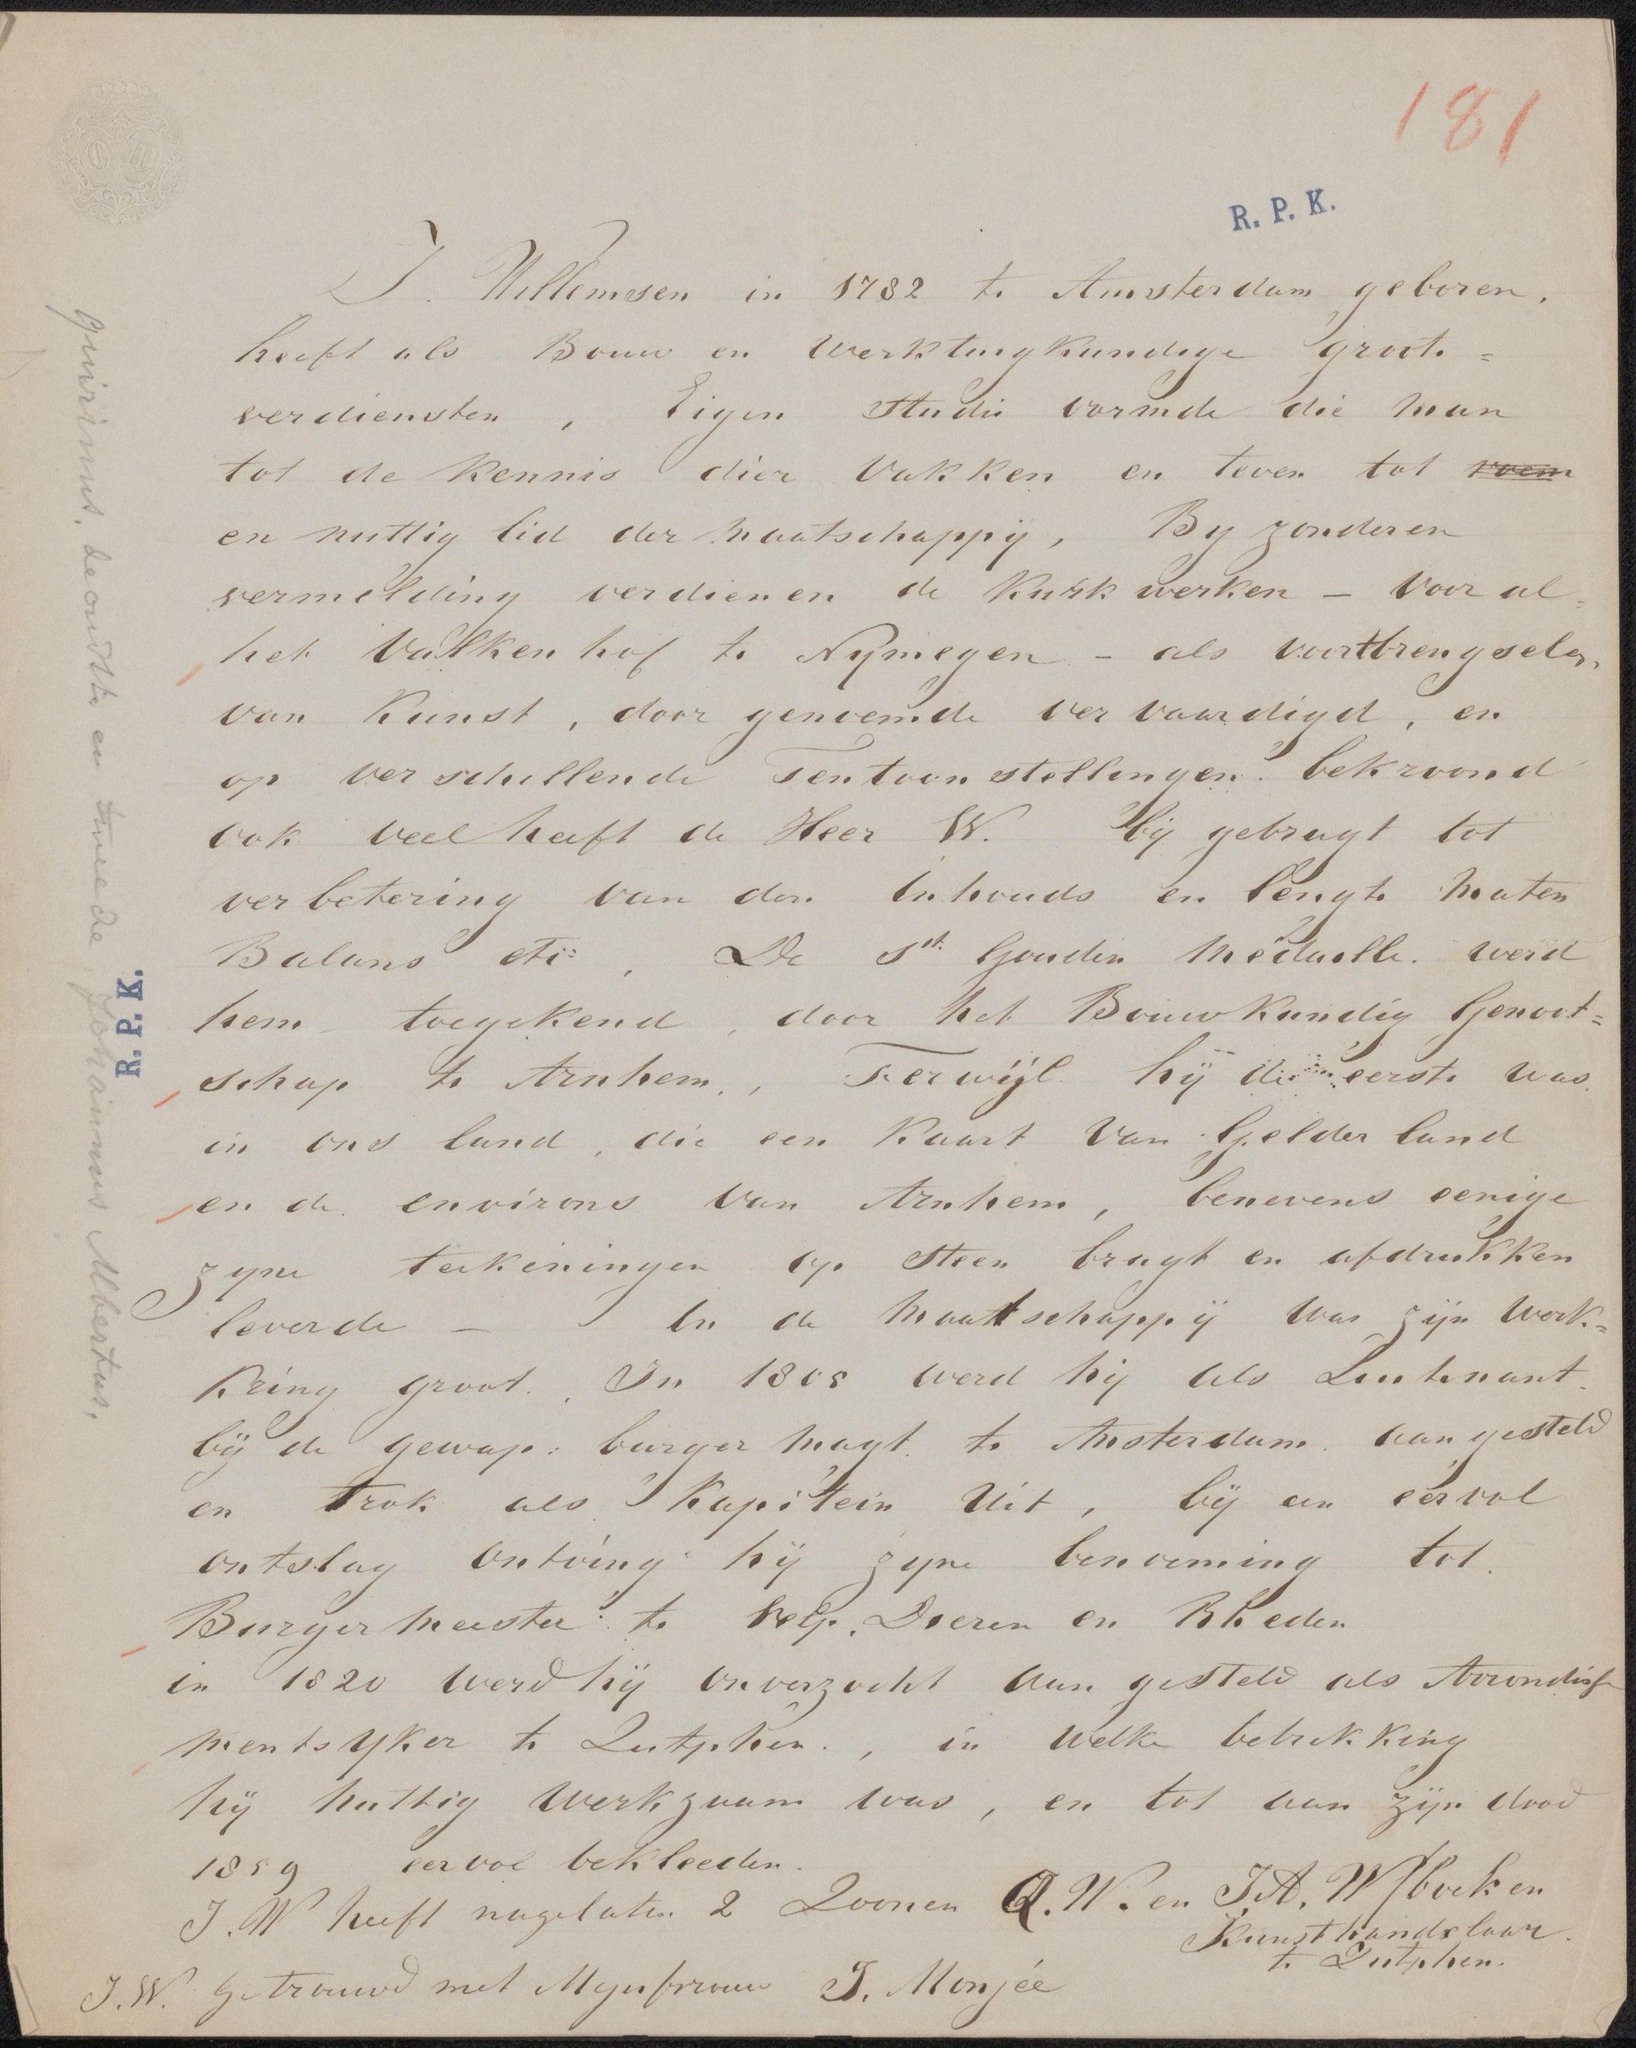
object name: manuscript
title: Handschrift betreffende Jan Willemsen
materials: ink, paper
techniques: pen, writing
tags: utrecht, print maker, draughtsman, christiaan kramm, drawing, the graphic arts, family life, architecture, arnhem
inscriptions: collector's mark: Lugt 2233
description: Handschrift bevat aantekening van Christiaan Kramm.